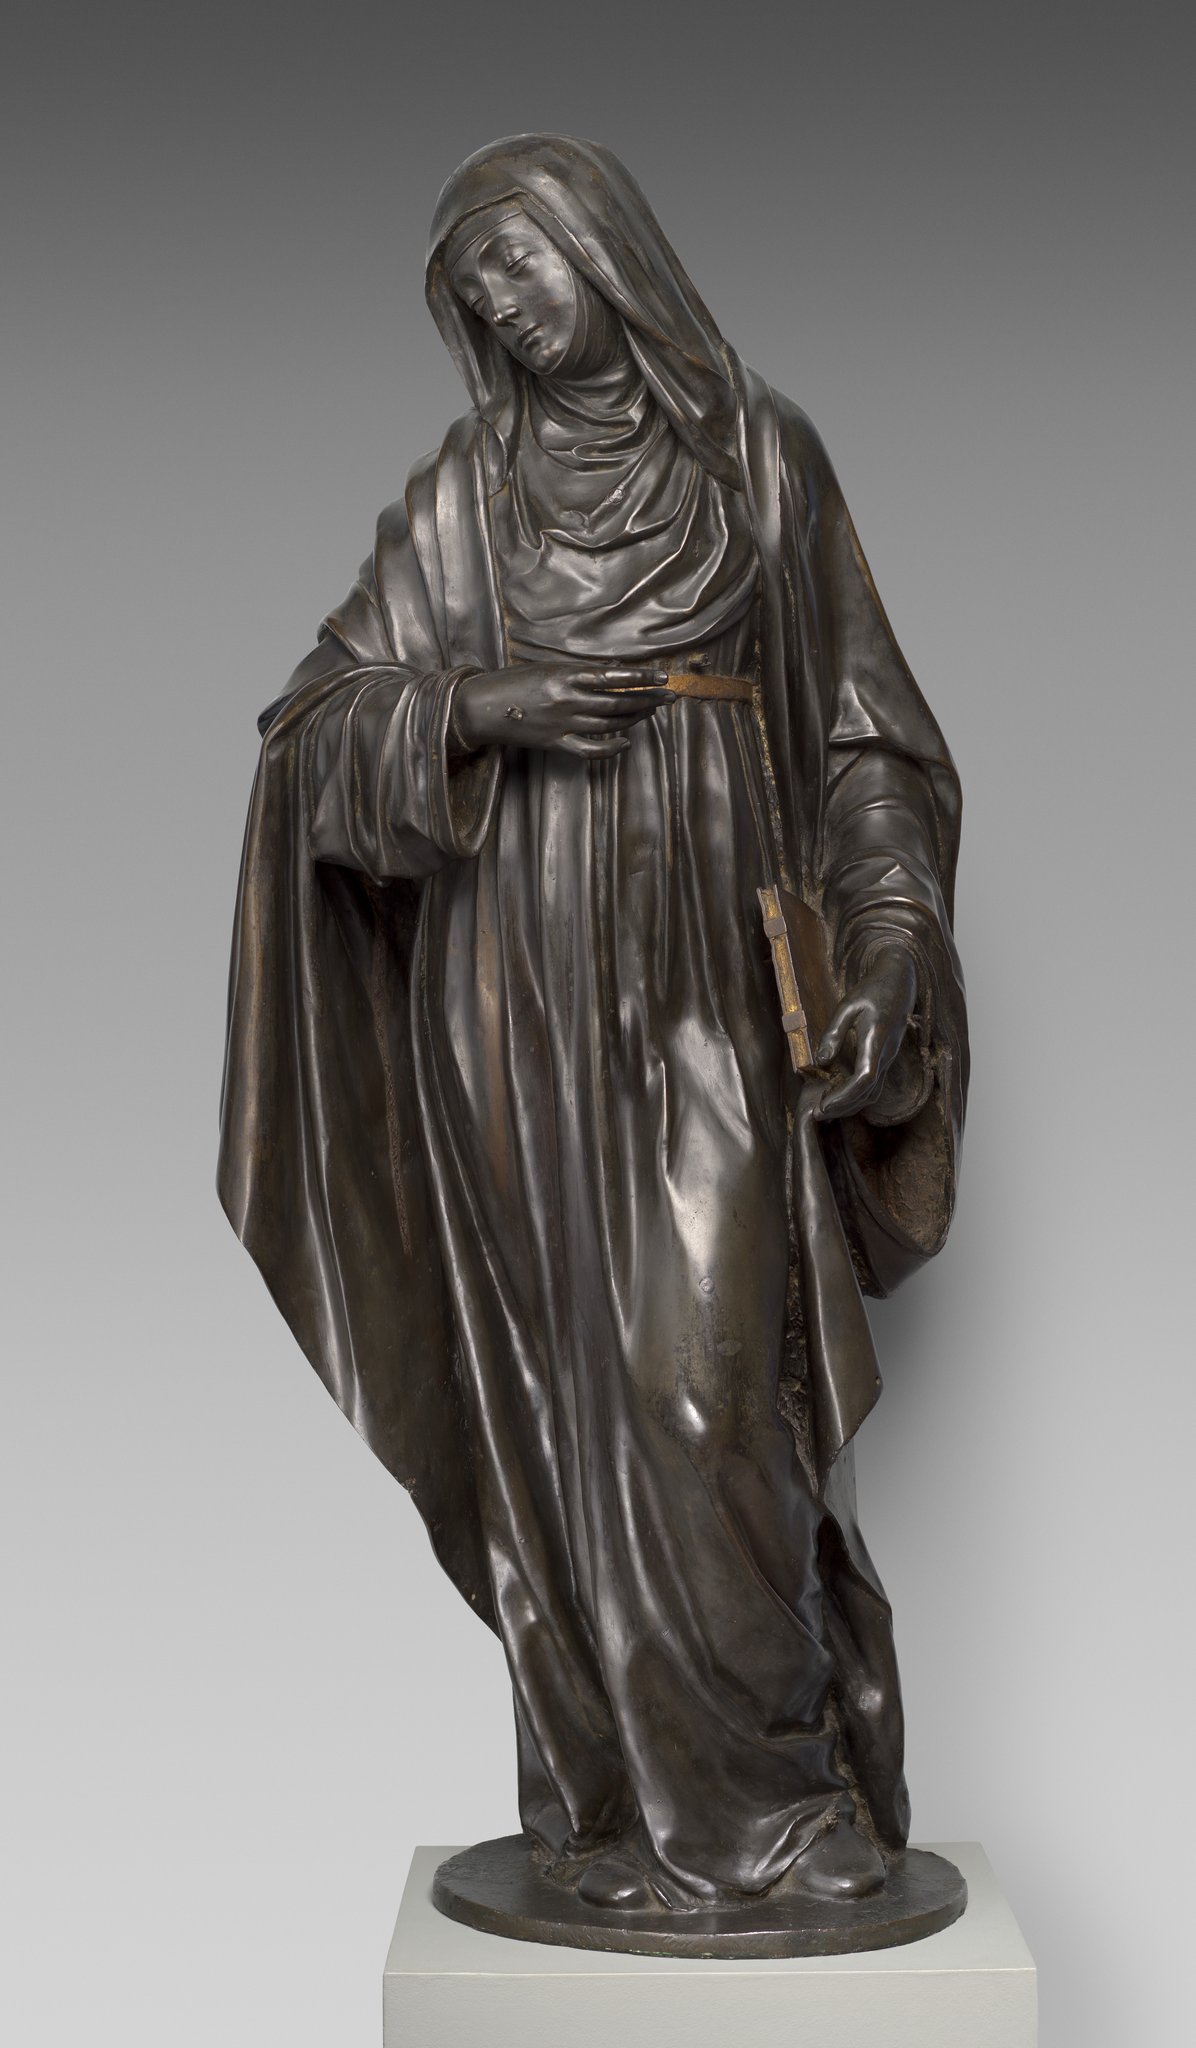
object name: statue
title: Saint Catherine of Siena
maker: fulvio signorini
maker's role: artist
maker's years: 1563-1609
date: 1600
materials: bronze, gilt, oil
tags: saint catherine